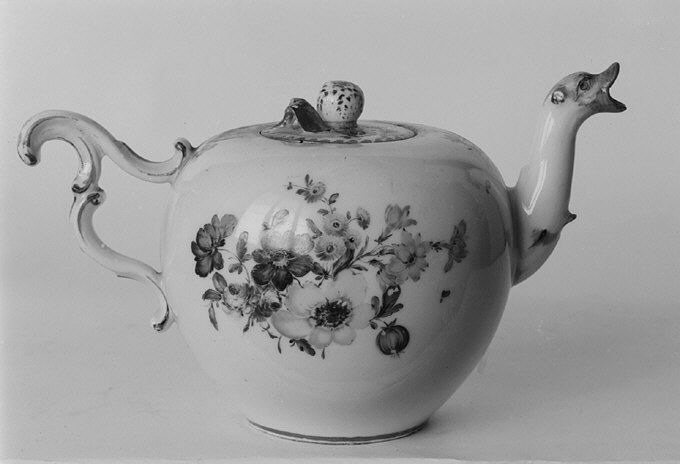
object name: teapot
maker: zurich pottery and porcelain factory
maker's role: factory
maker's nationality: swiss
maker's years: 1763-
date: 1770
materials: hard paste porcelain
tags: flowers